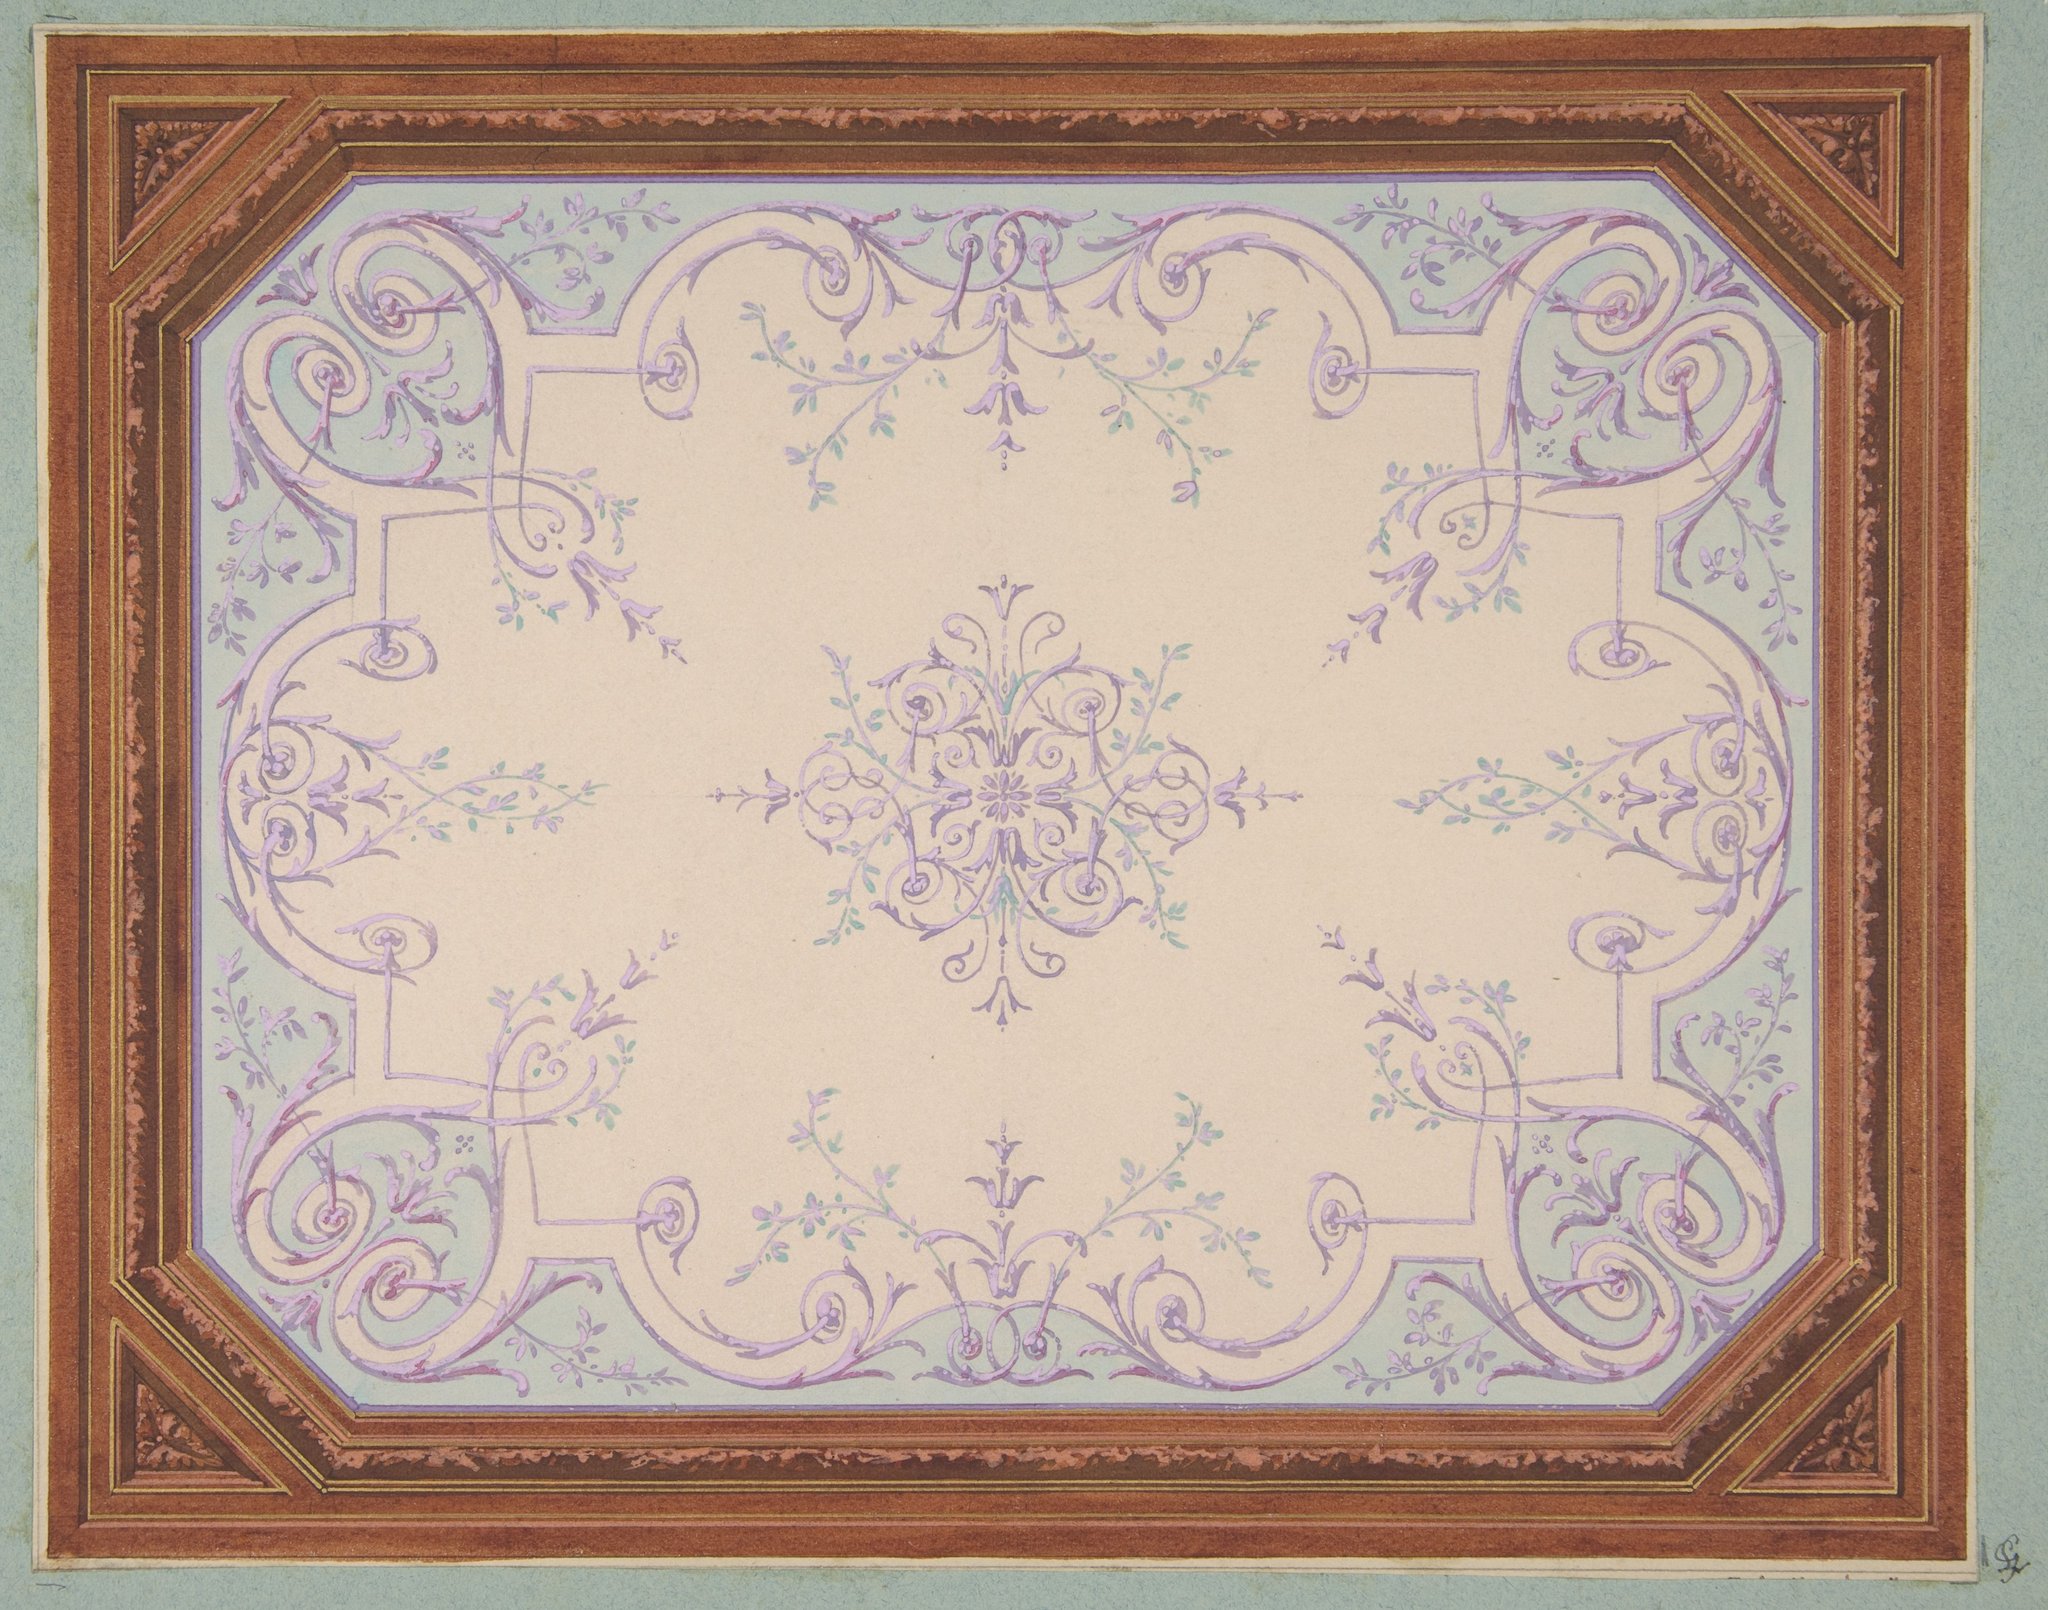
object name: drawing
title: Design for the decoration of a ceiling in rinceaux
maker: jules-edmond-charles lachaise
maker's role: artist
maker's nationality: french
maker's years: 1897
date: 1830-1897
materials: gold paint, ink, watercolor, paper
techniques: pen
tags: ceilings